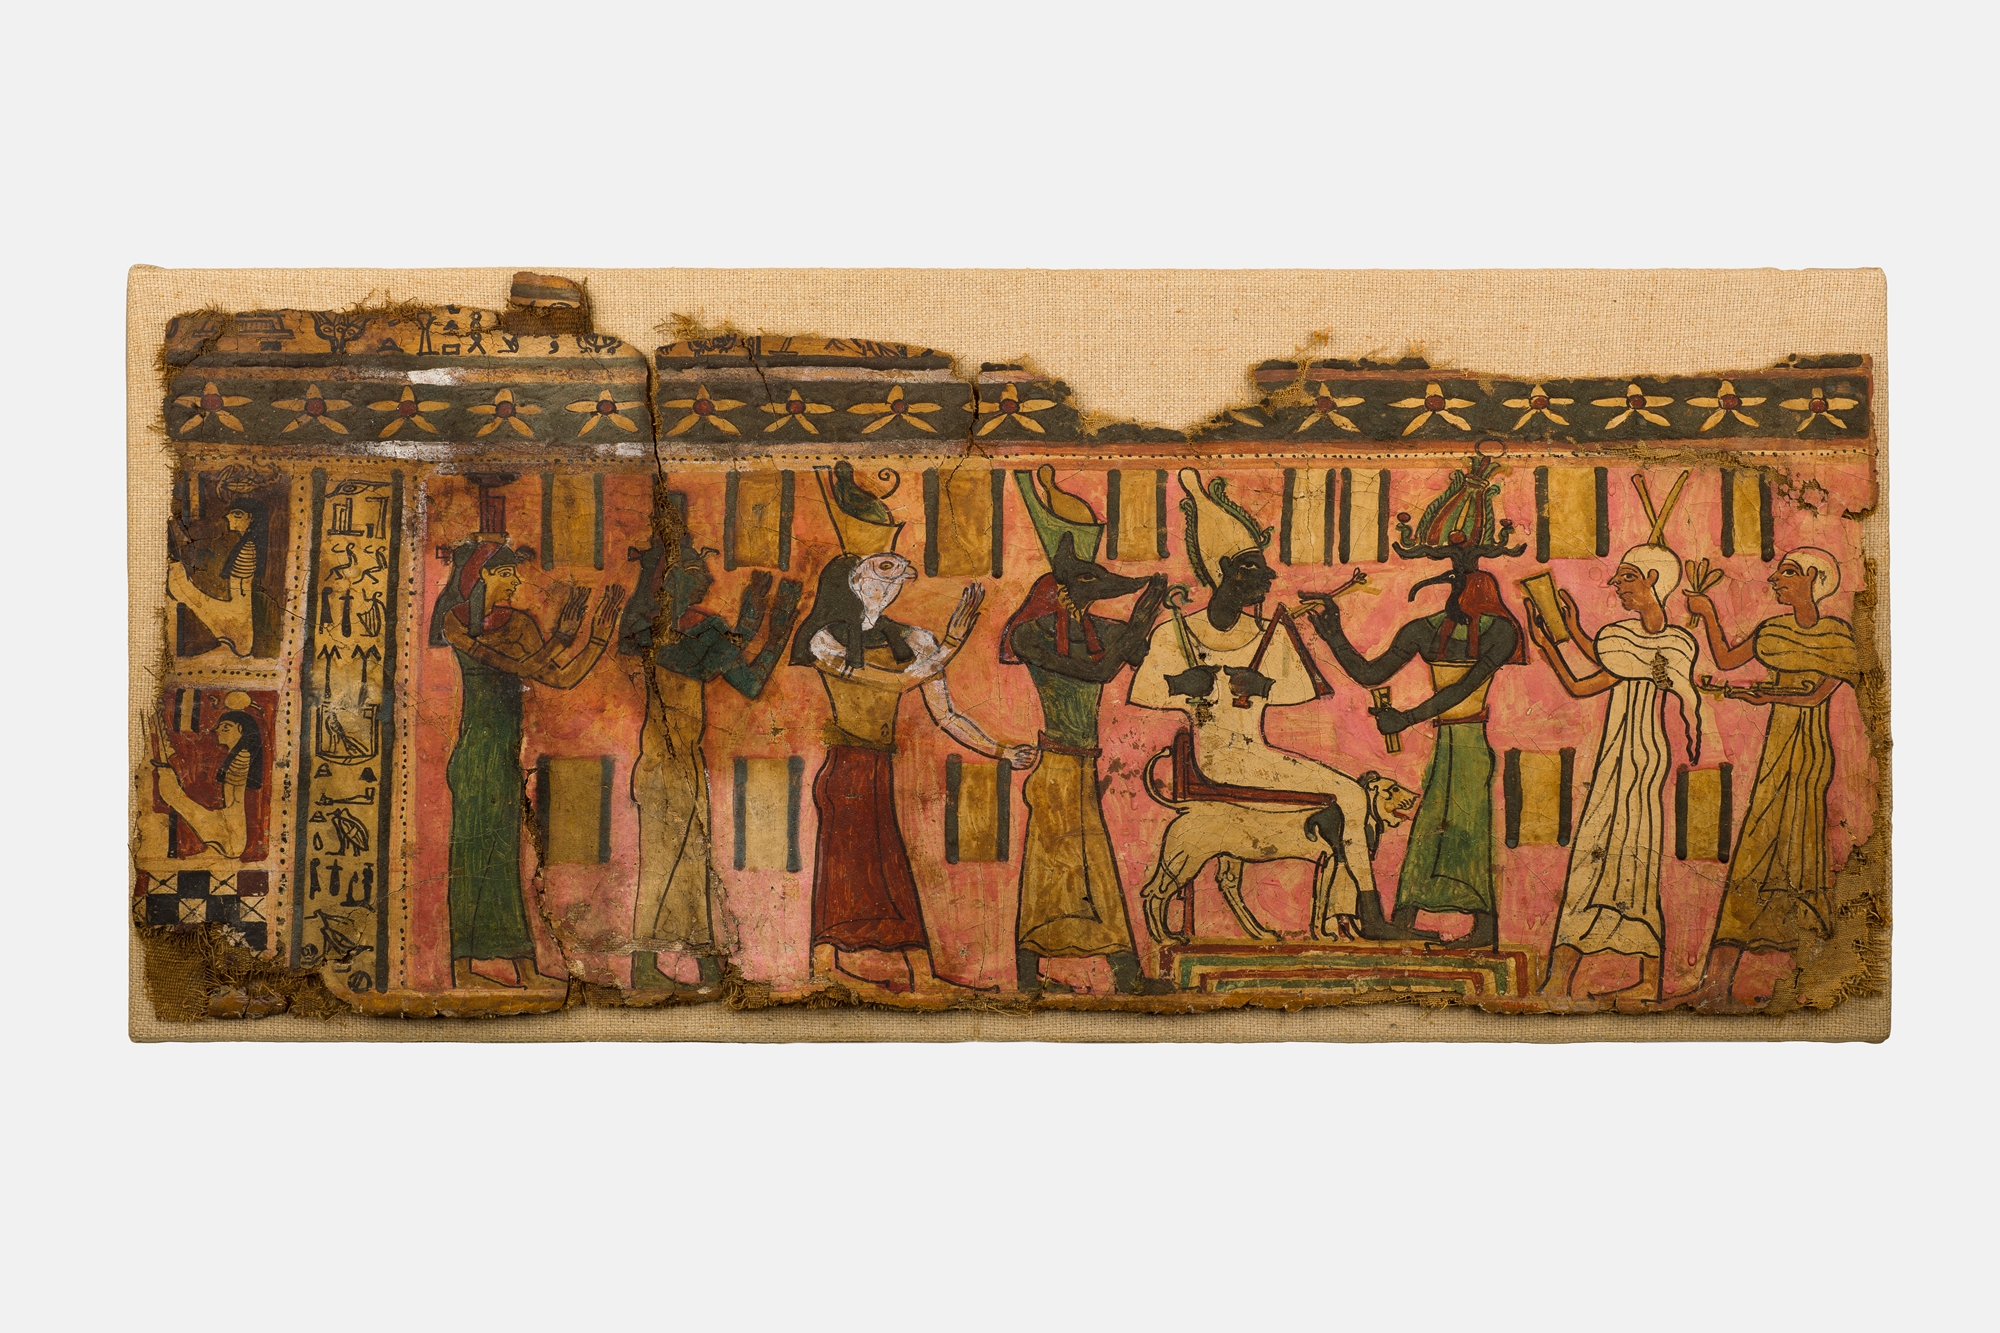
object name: cartonnage fragment, painted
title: Cartonnage fragment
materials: linen, paint, plaster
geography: egypt